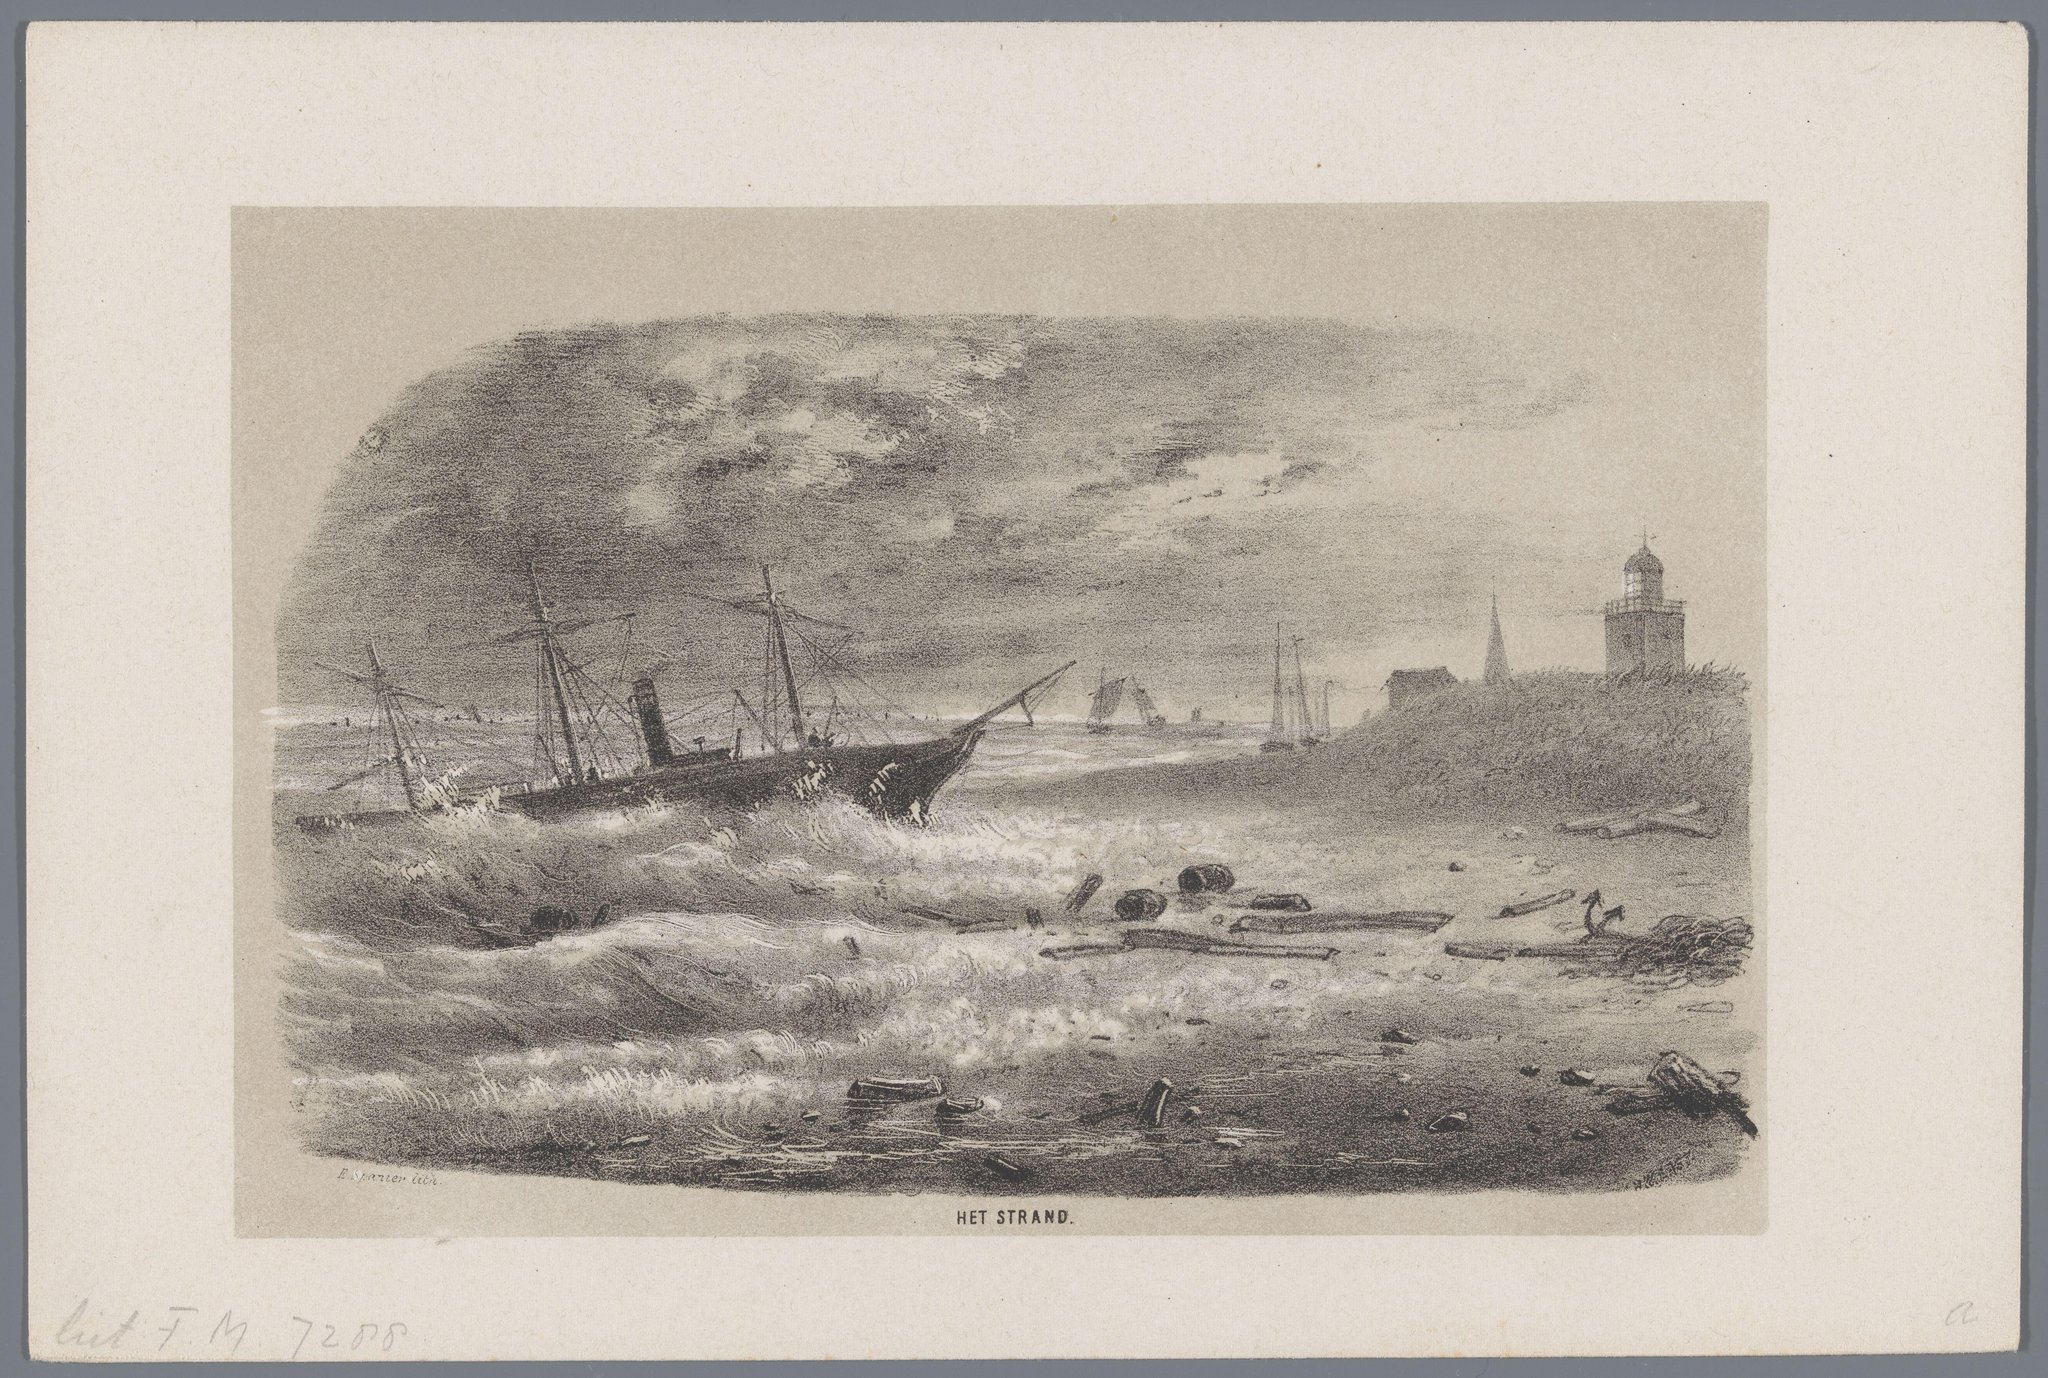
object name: print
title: Album van tien gelithographieerde schetsen, voorstellende Tooneelen van de Verwoesting, Aangerigt door den storm van 28 mei 1860 in het 's Gravenhaagsche Bosch, te Scheveningen, enz.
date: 1860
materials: paper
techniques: tone lithography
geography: netherlands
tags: storm at sea, storm on land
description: Een schip in problemen bij het strand tijdens de storm. Onderdeel van het album met tien losse steendrukken in een papieren omslag met voorstellingen van de schade aangericht door de 'Pinksterstorm' van 28 mei 1860 in het Haagse Bos en omgeving.